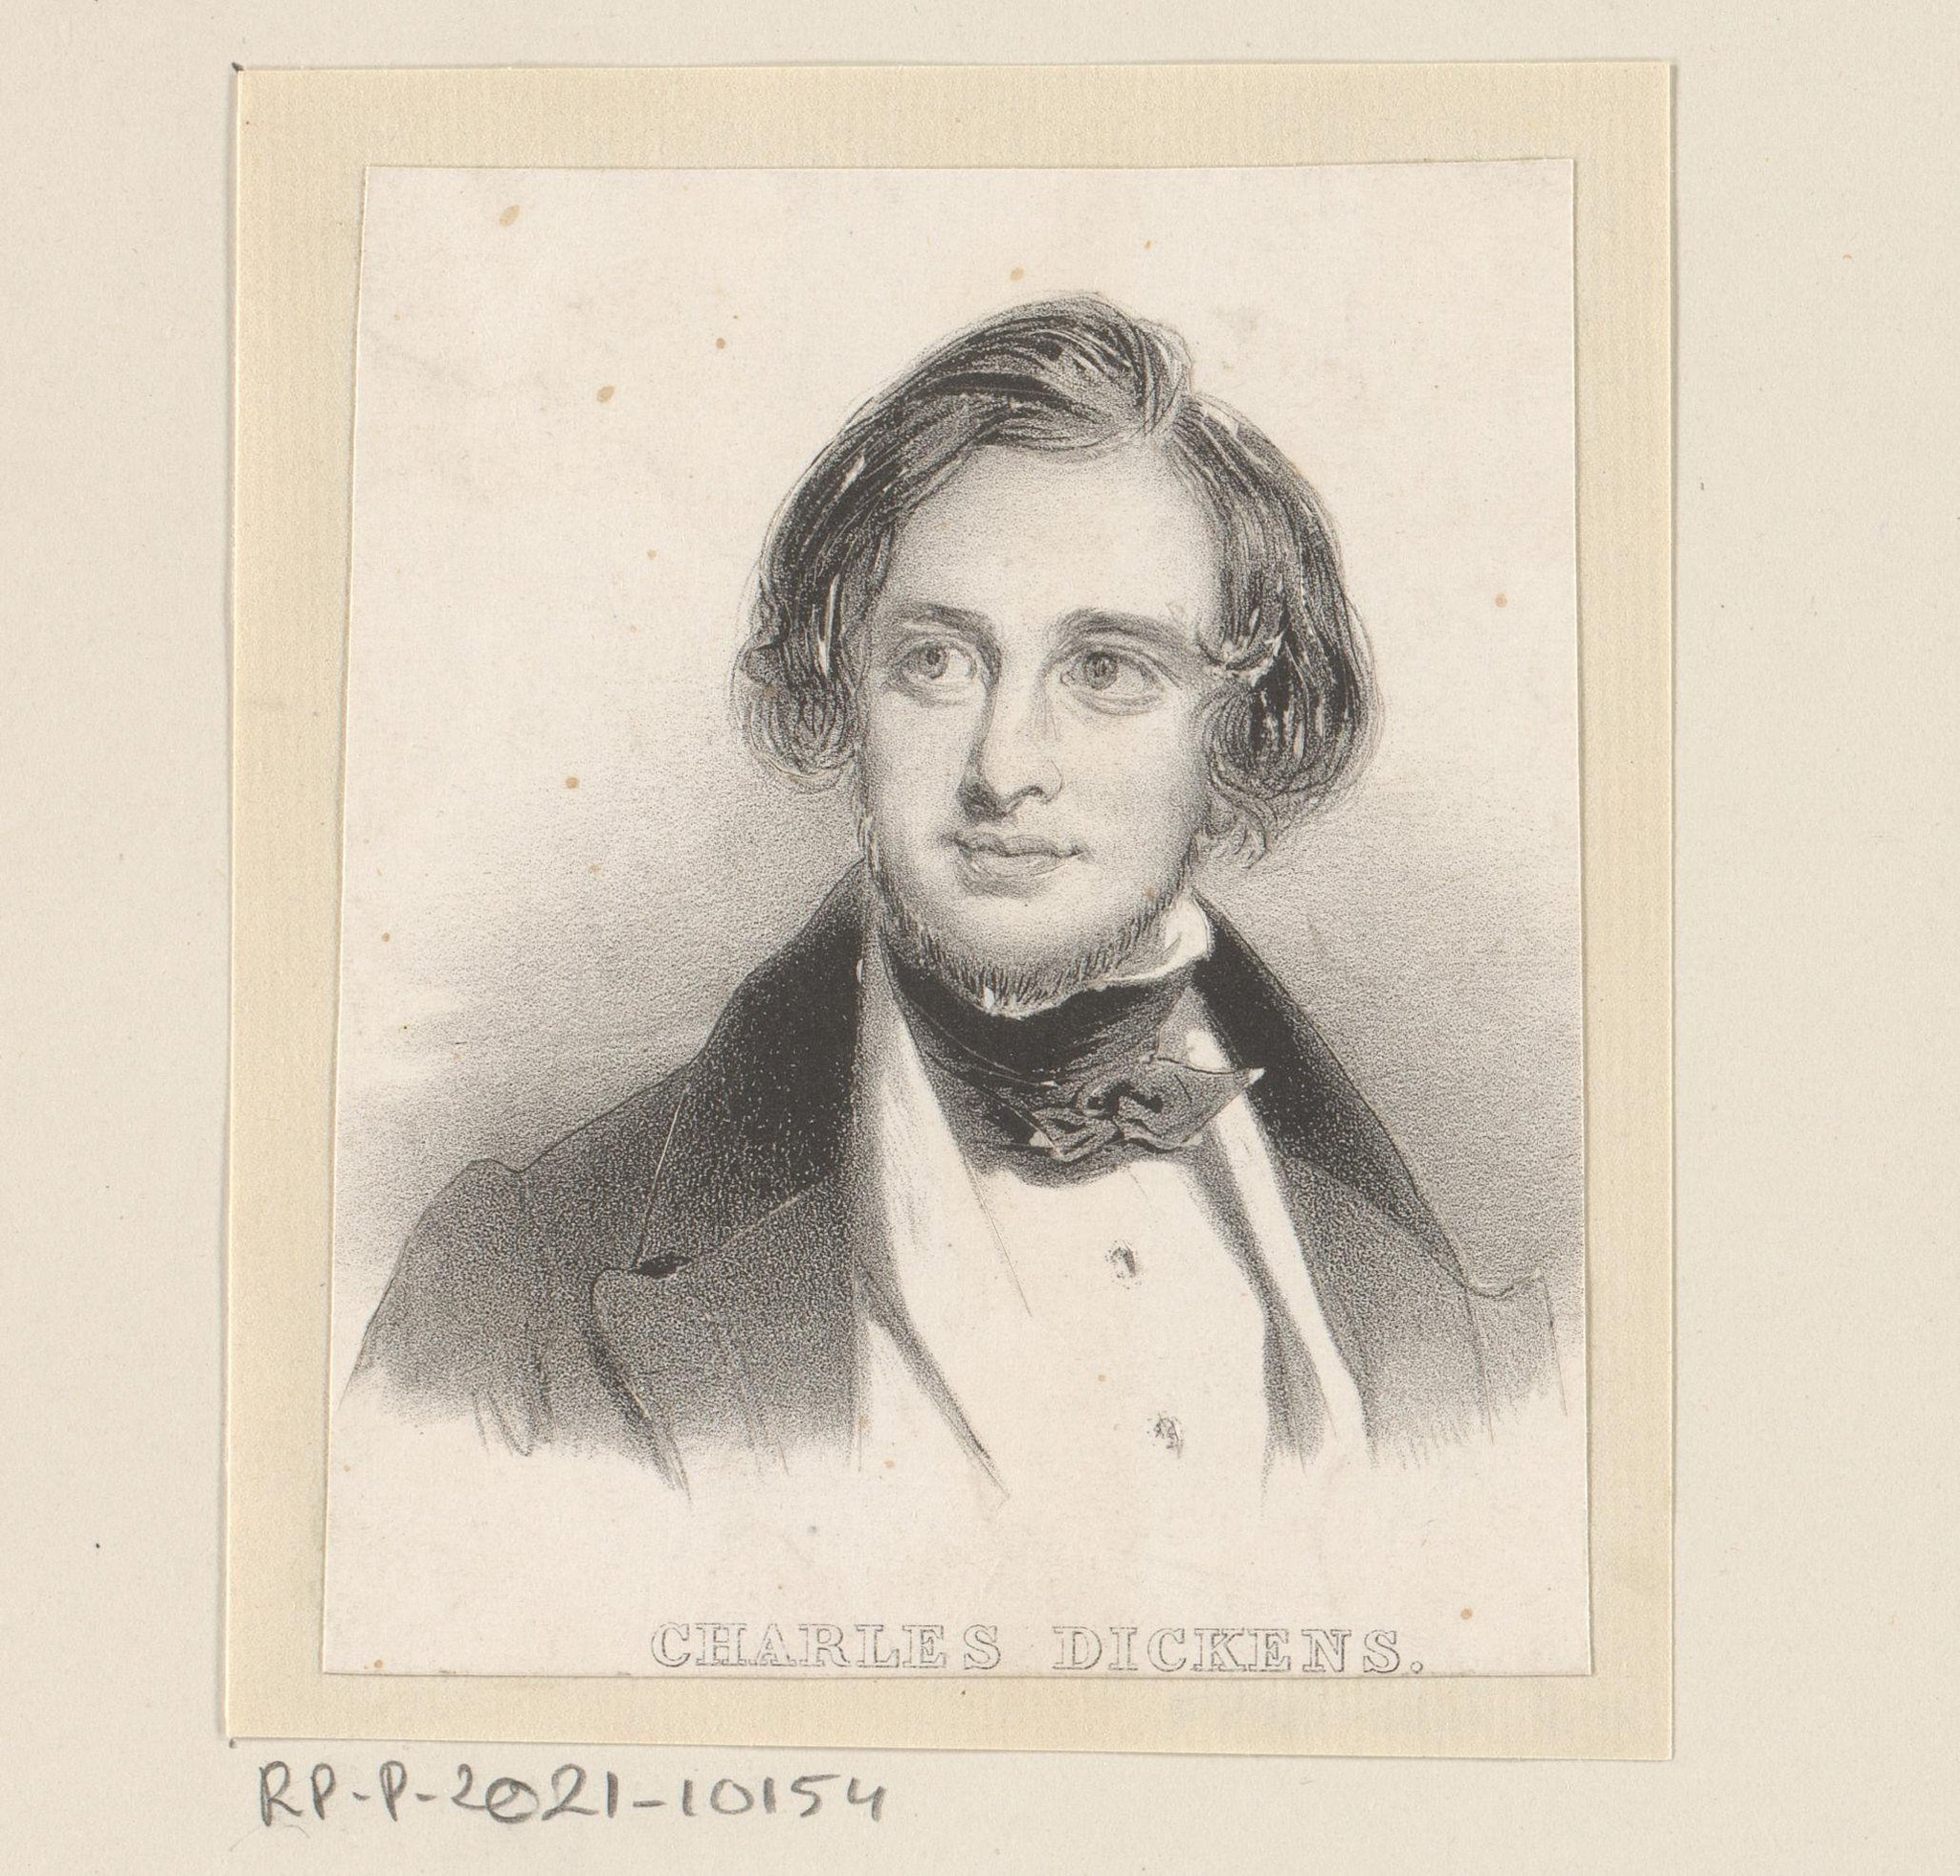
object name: print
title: Charles Dickens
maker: Anonymous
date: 1840-1850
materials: paper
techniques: lithograph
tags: historical persons, portrait of a writer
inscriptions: inscription: ‘1812-1870’